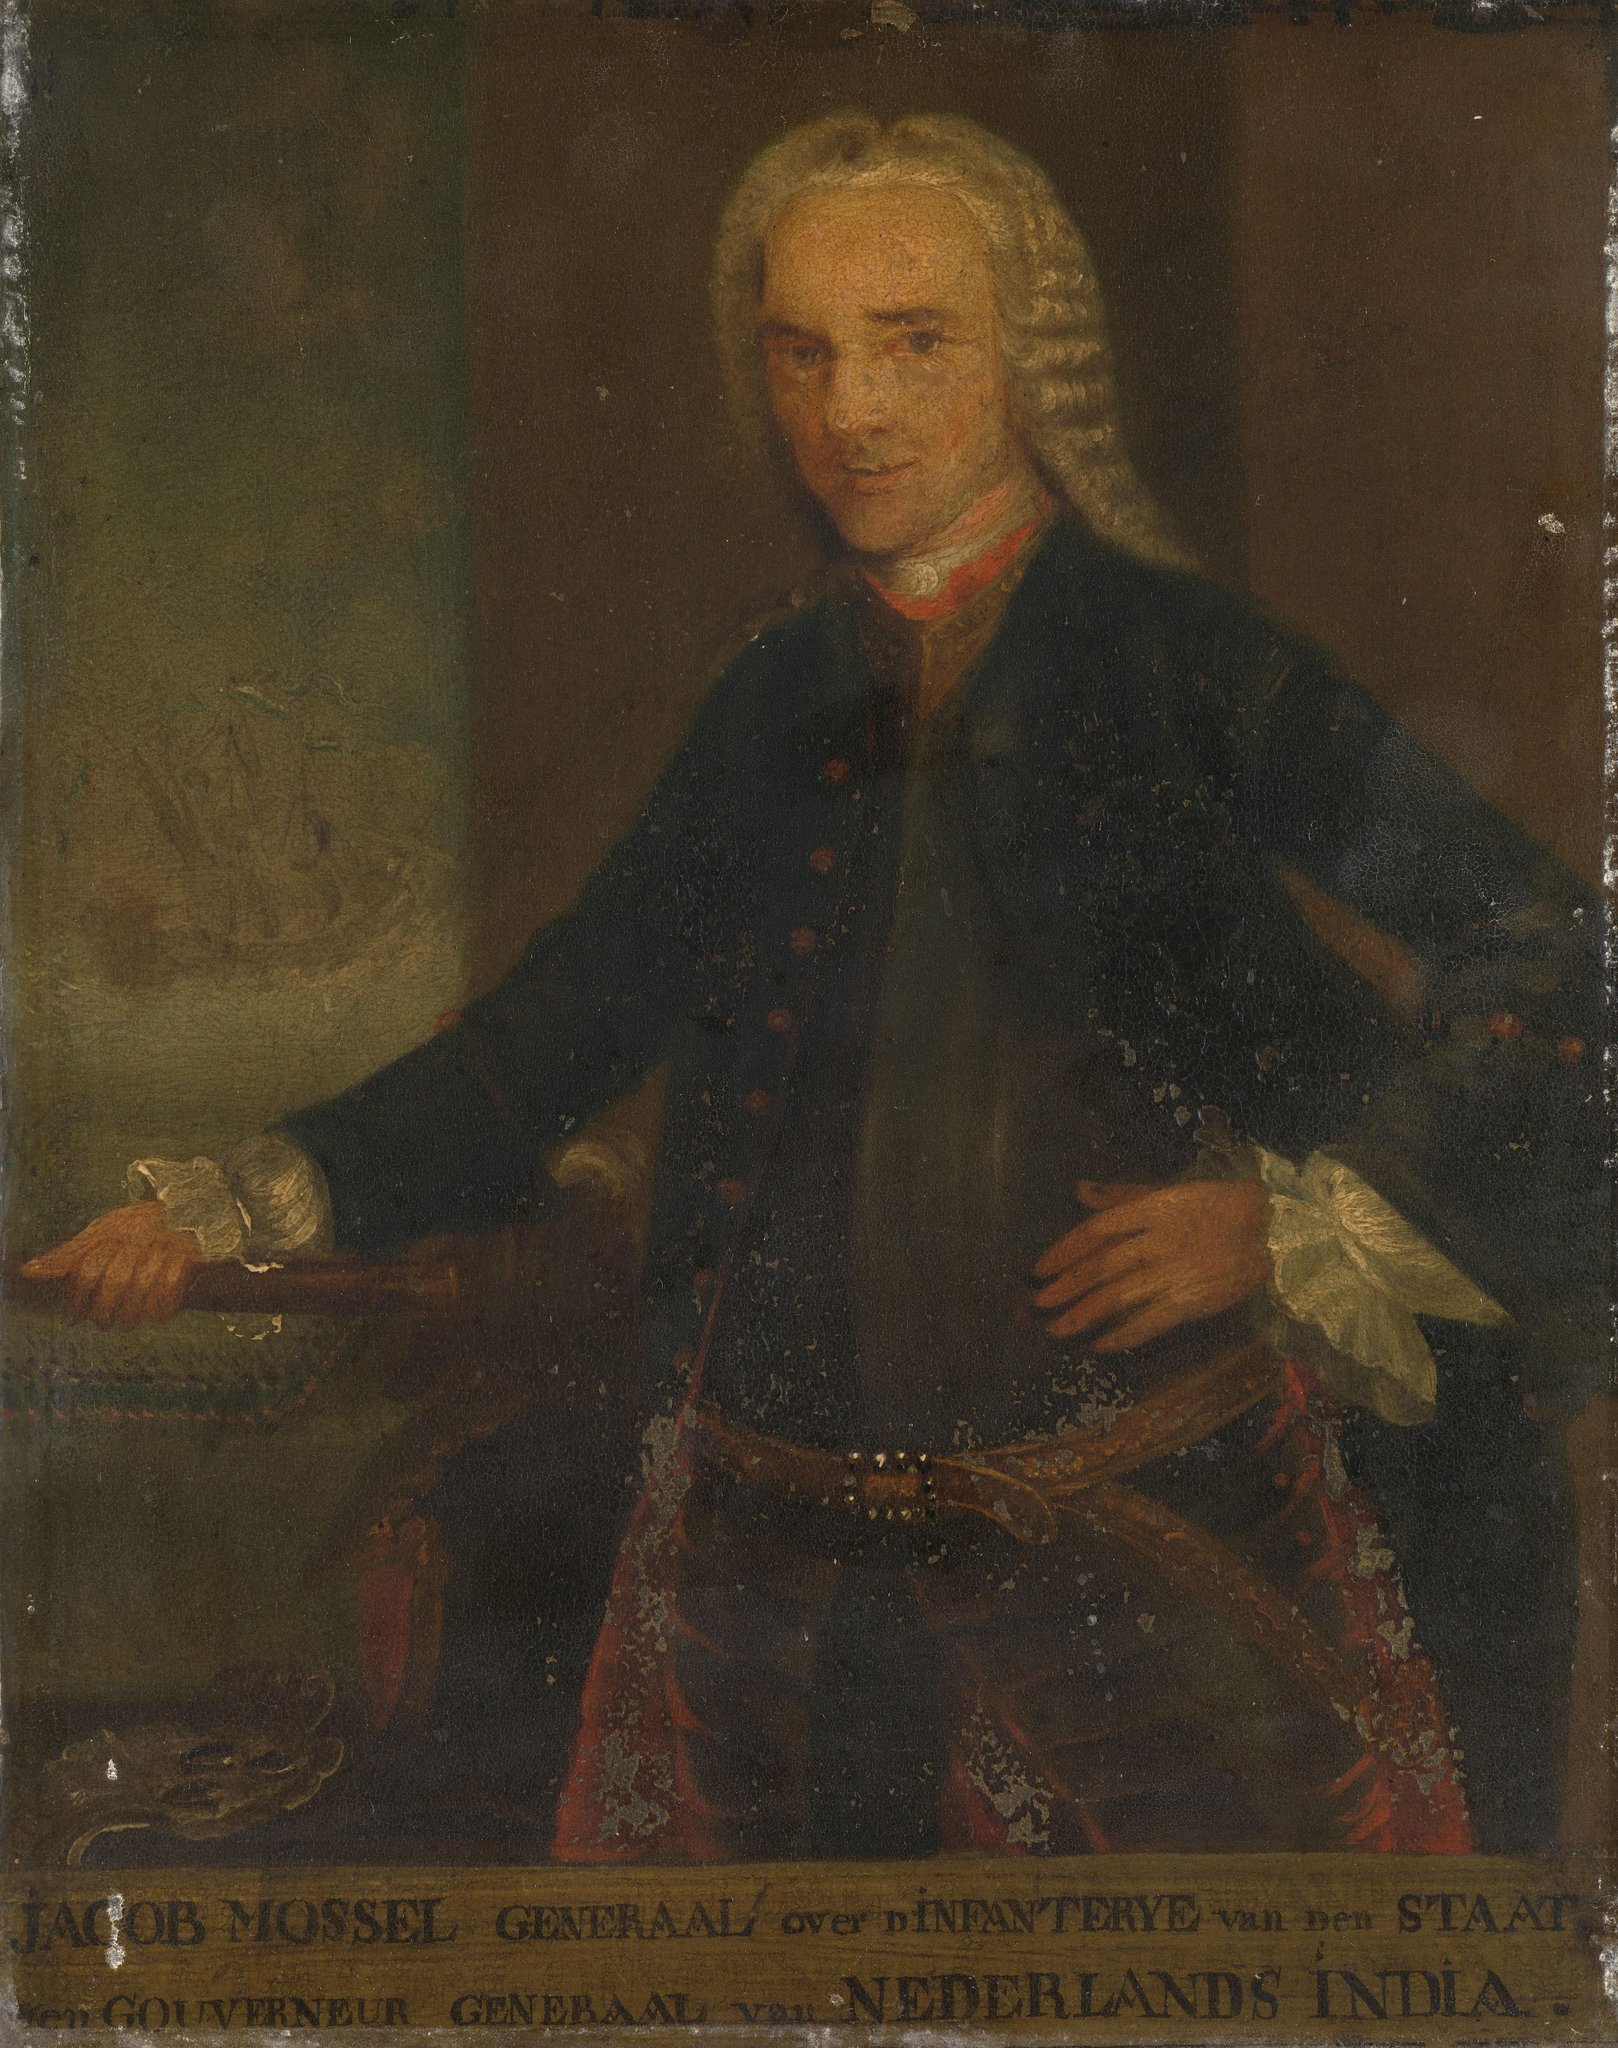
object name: painting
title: Portrait of Jacob Mossel, Governor-General of the Dutch East India Company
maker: Anonymous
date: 1750-1799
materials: copper, oil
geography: netherlands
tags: enkhuizen, dutch east indies, the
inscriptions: inscription: ‘Jacob Mossel Generaal over d'Infanterye van den Staat en Gouverneur Generaal van Nederlands India’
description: Portret van Jacob Mossel (1704-61). Gouverneur-generaal (1750-61). Heupstuk, staande in wapenrusting naar links. Commandostaf in de rechterhand, de linkerhand in de zij. Op de achtergrond een schip op zee. Onderdeel van een reeks van kopieën naar portretten van de gouverneurs-generaal van het voormalige Nederlands Oost-Indië, waarschijnlijk afkomstig van de Verenigde Oostindische Compagnie.